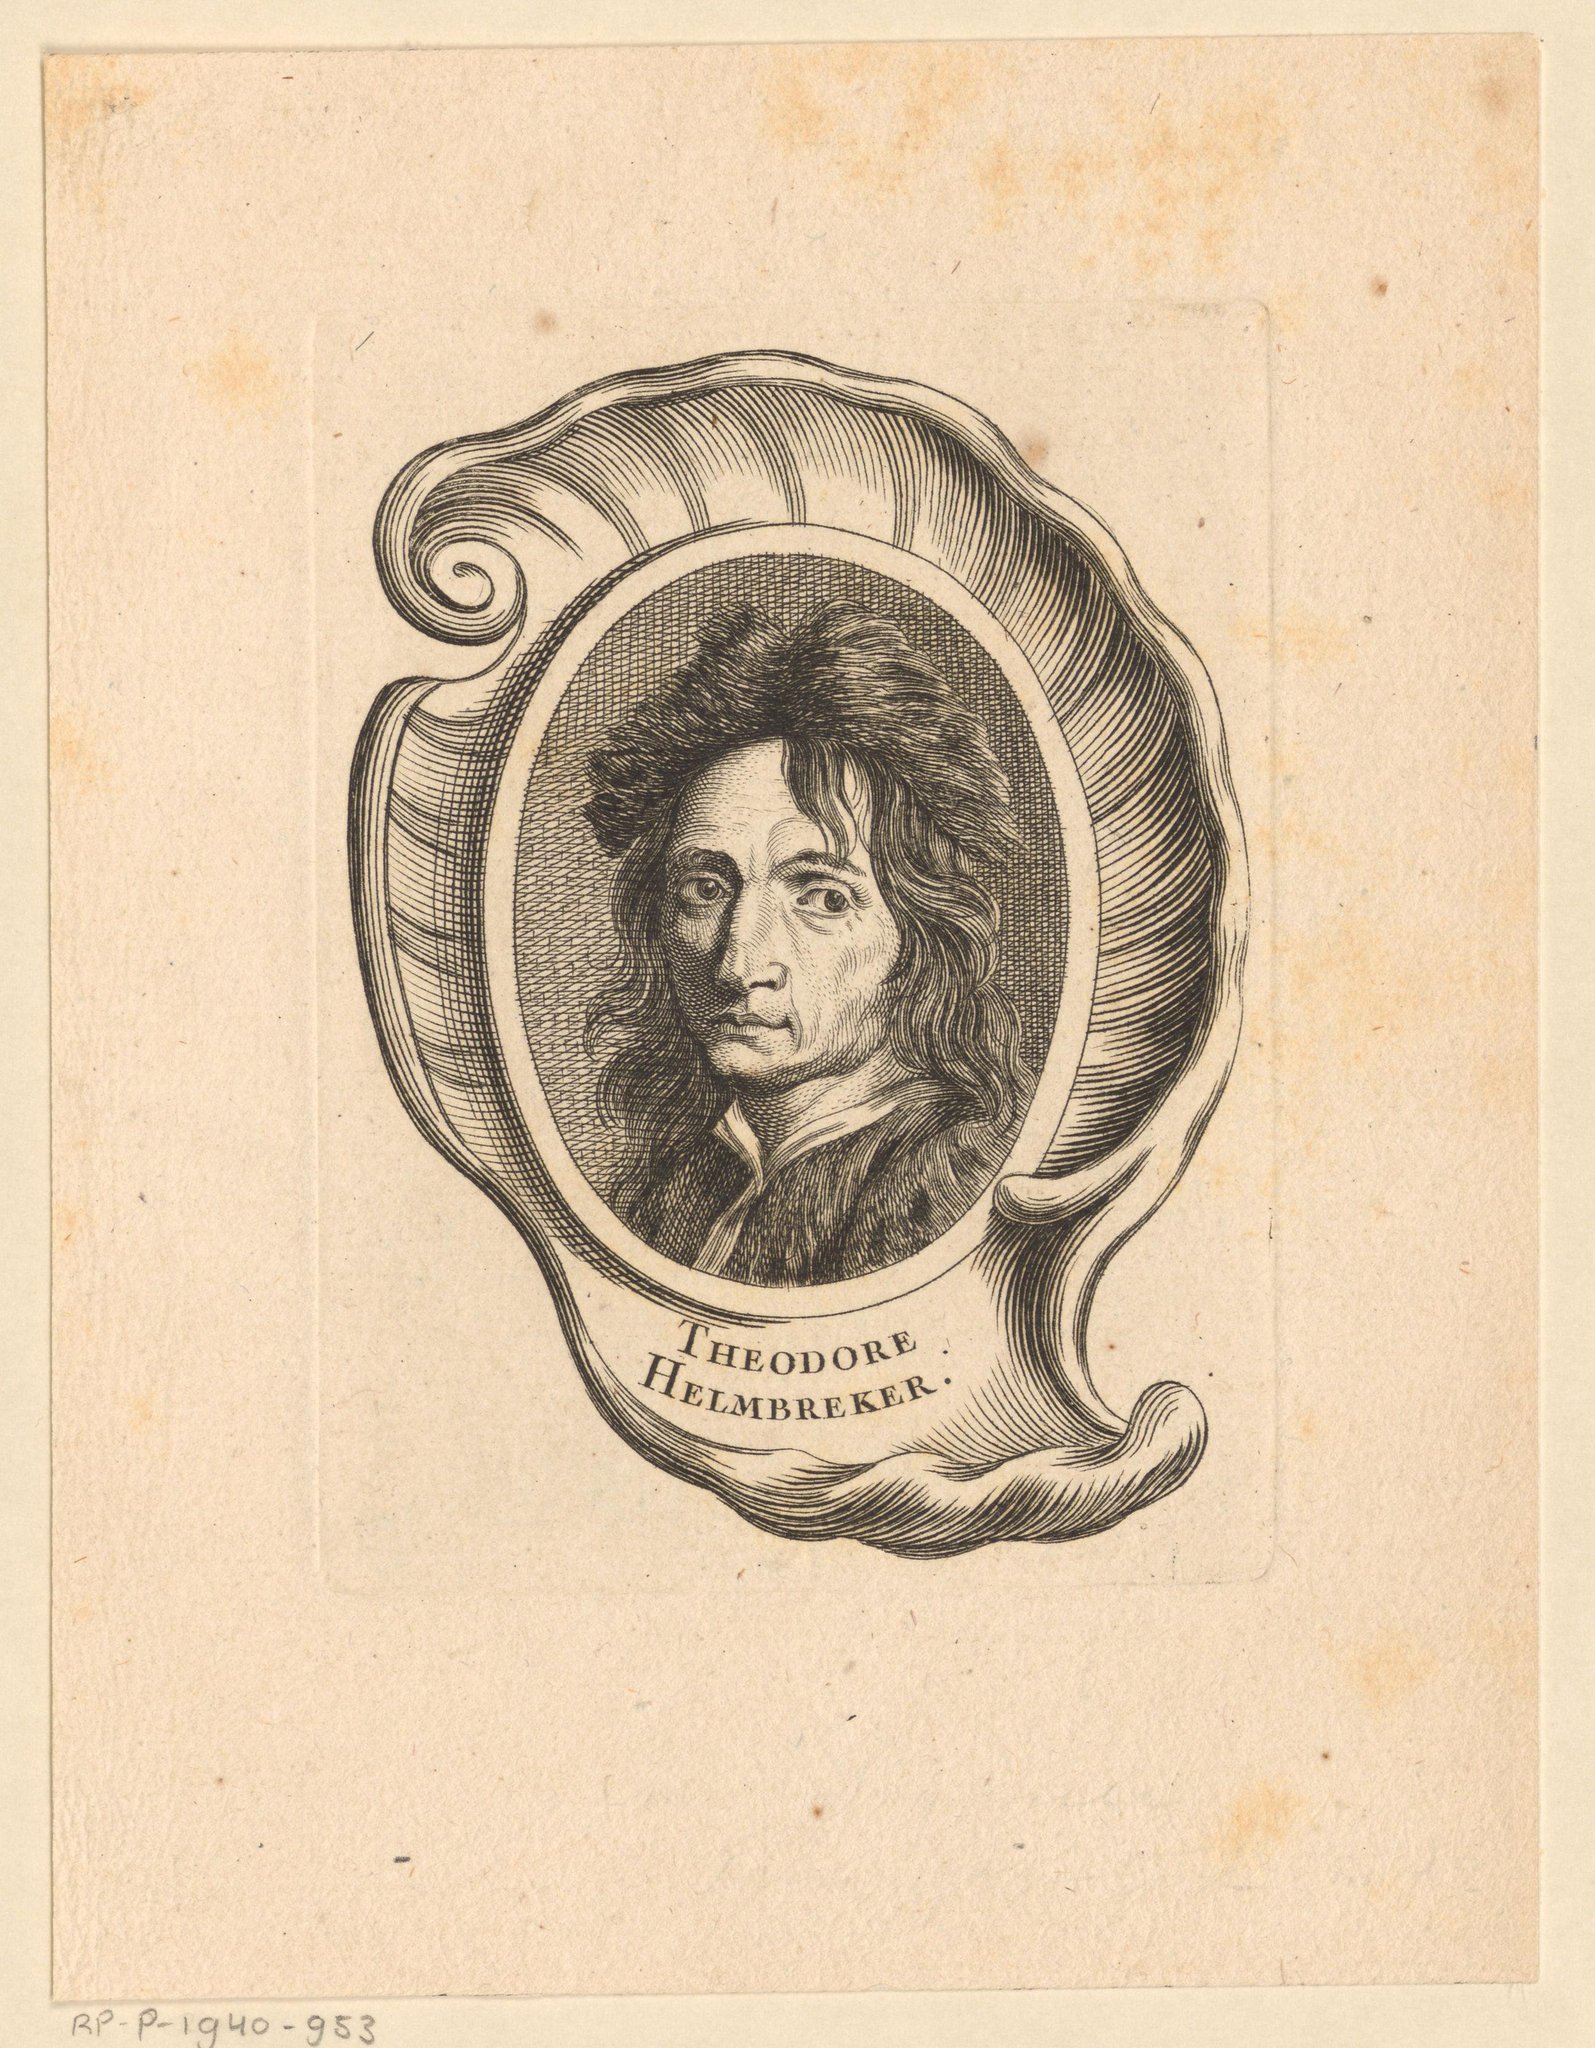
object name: print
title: Portret van Dirck Helmbreeker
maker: Anonymous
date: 1745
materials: paper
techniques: engraving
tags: haarlem, rome, draughtsman, dirck helmbreeker, historical persons, portrait, self-portrait of painter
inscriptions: collector's mark: Lugt 2228, collector's mark: Lugt 2760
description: Prent met tekst op verso gebruikt in: Dézallier d’Argenville, Antoine-Joseph. Abrégé de la vie des plus fameux peintres. Parijs: de Bure l’aîné, 1745.